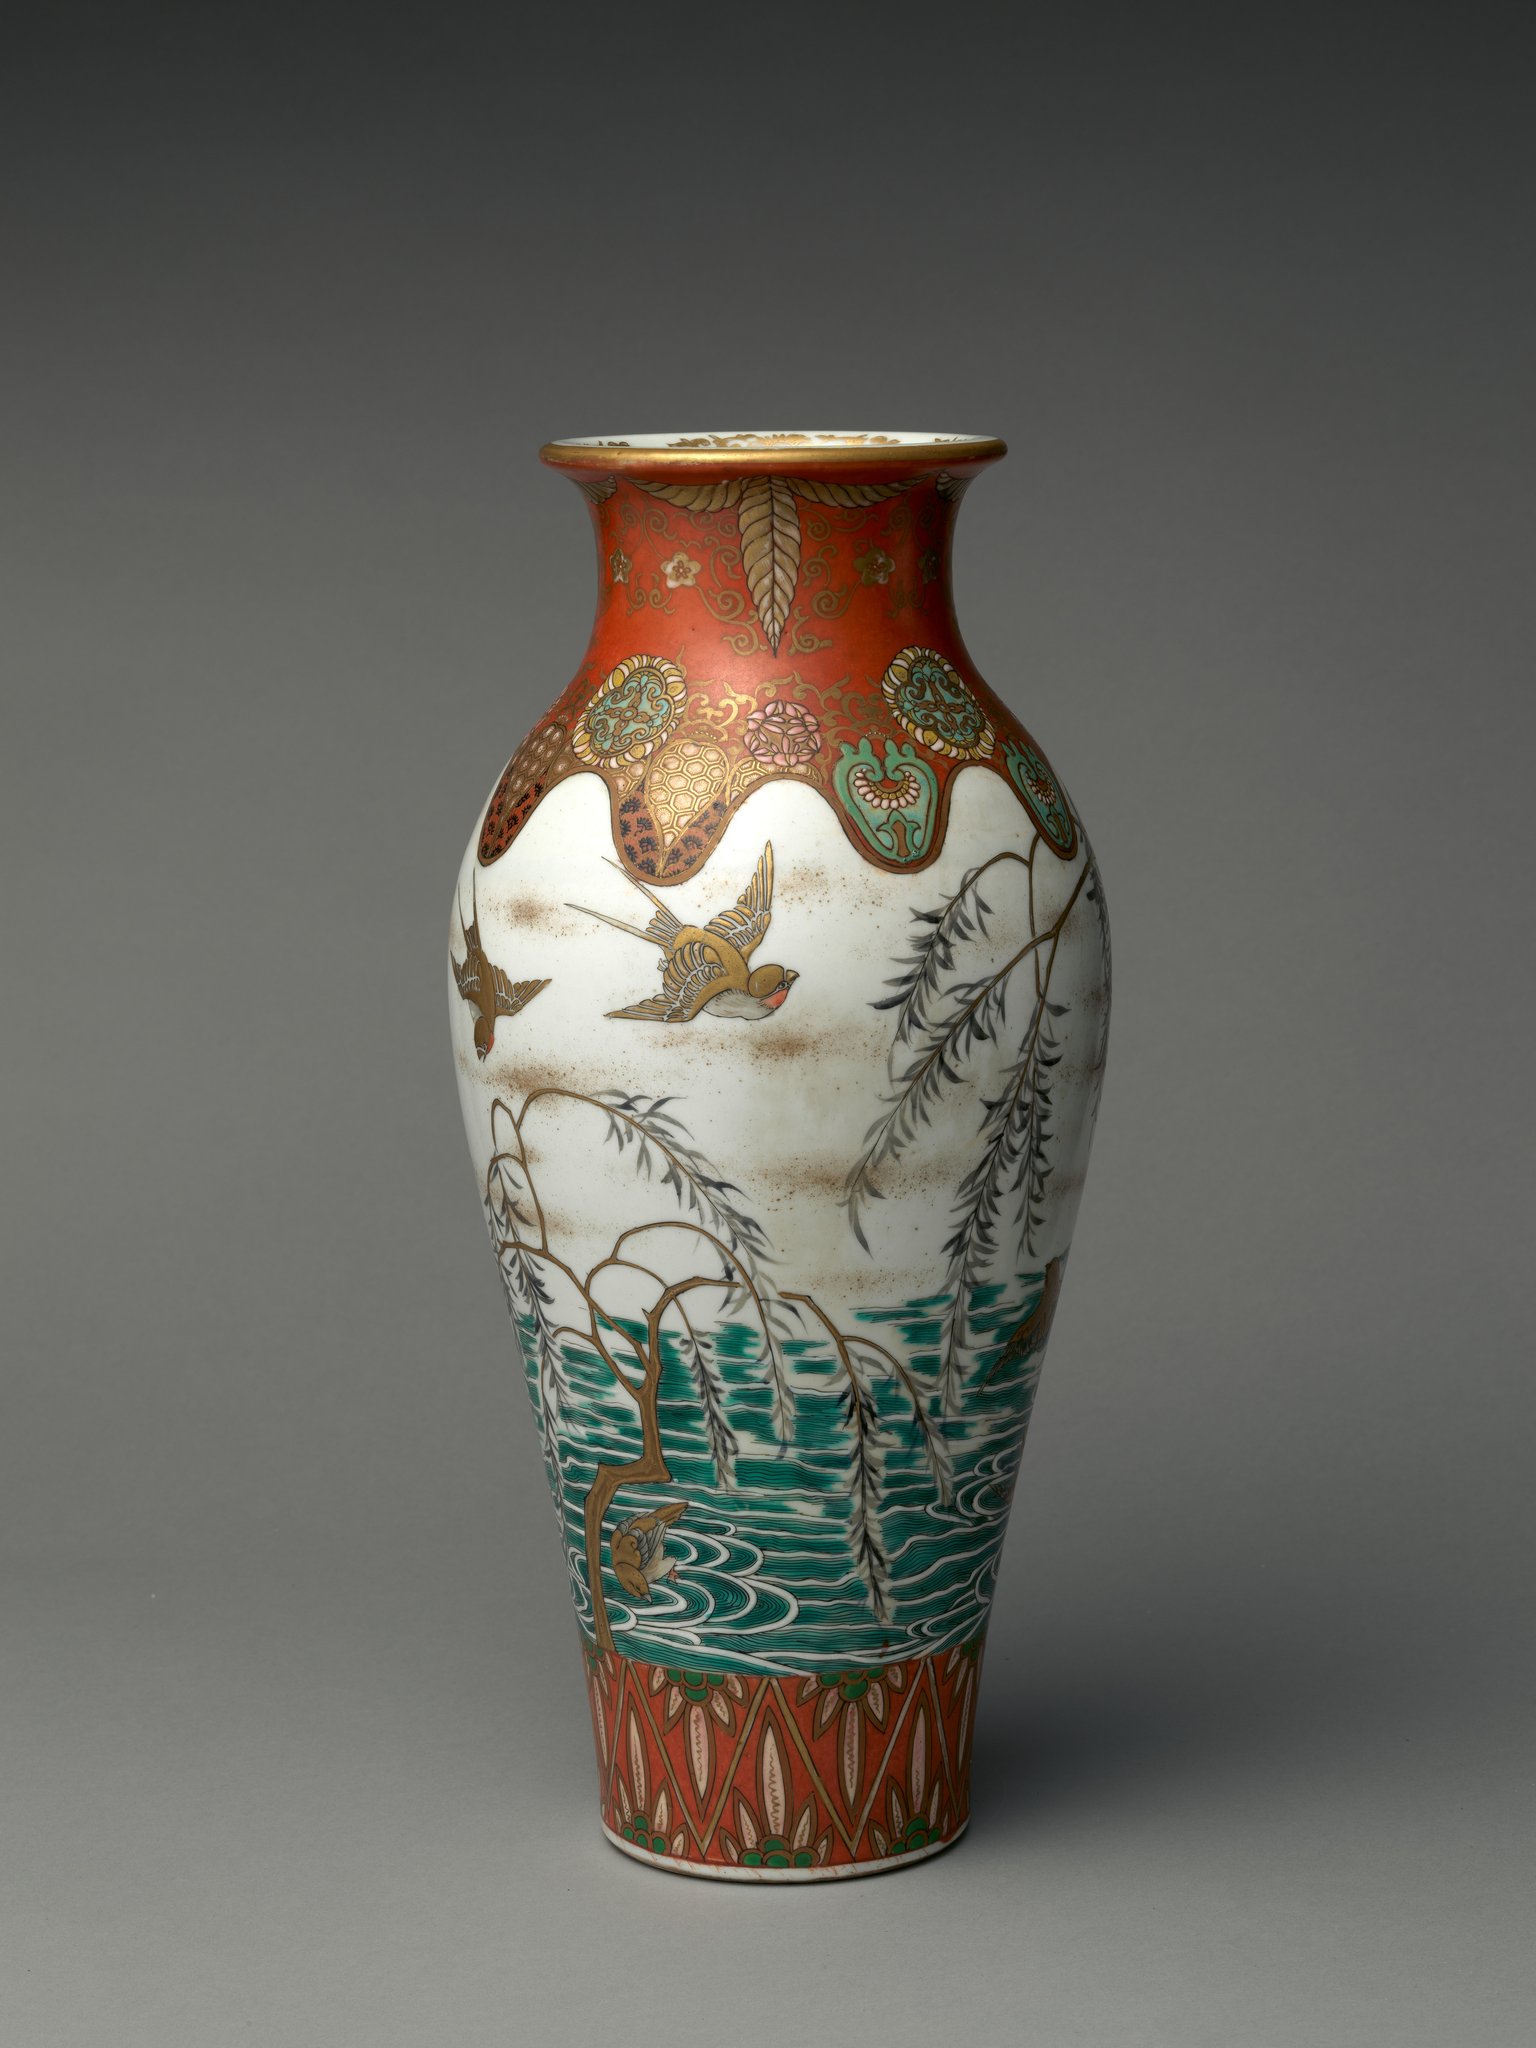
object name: vase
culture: japanese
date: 1834-1866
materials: enamel, gold, porcelain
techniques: overglaze, polychrome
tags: birds,trees